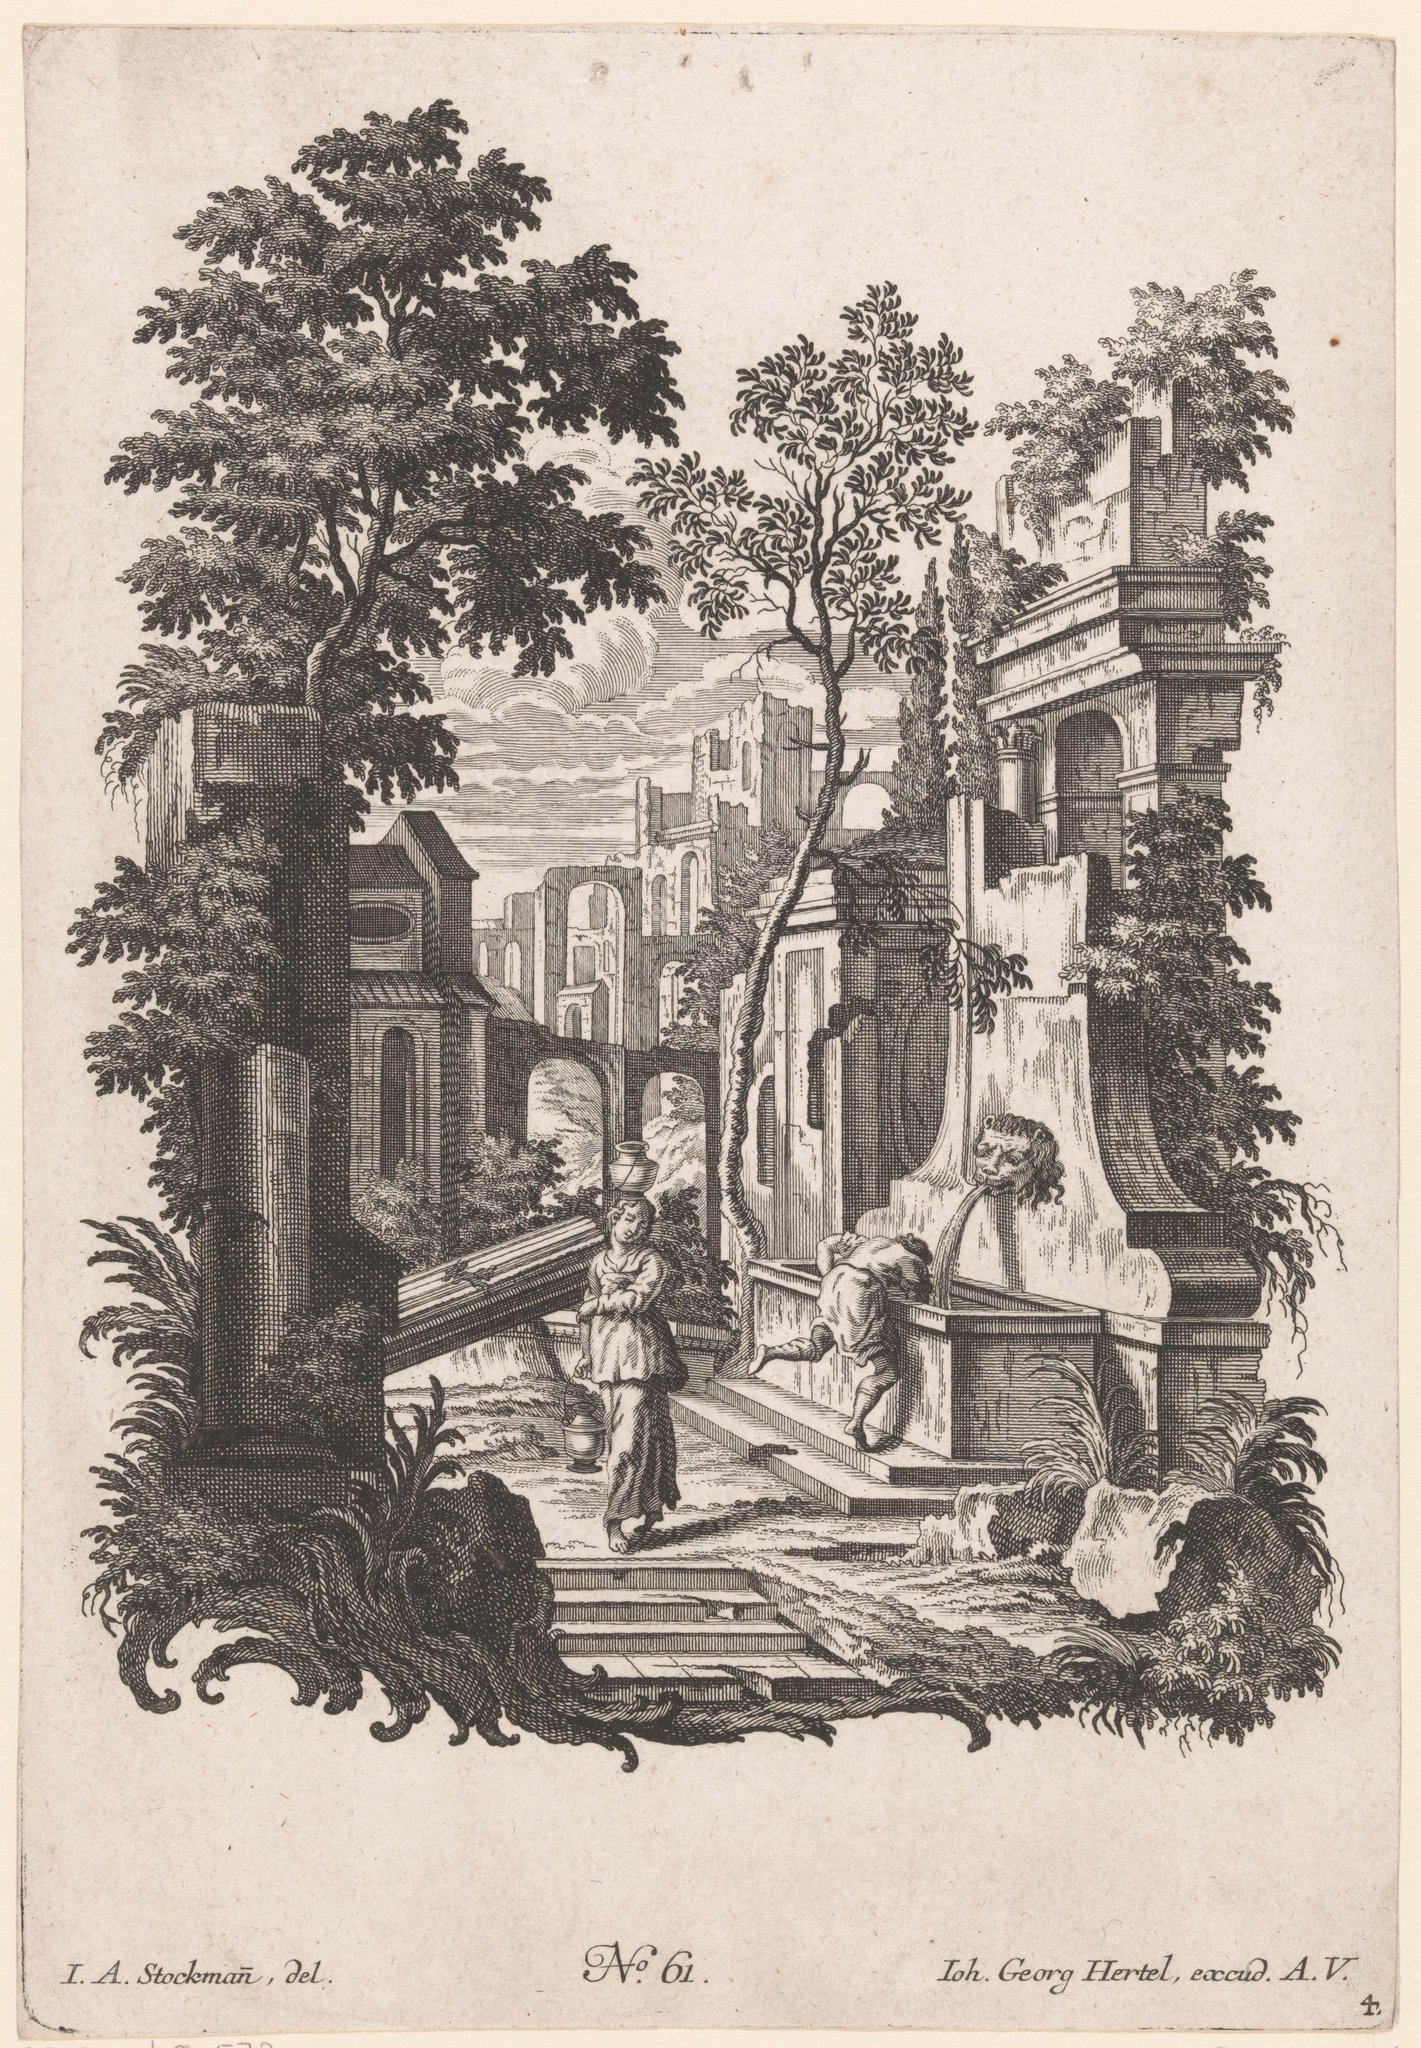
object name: print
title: Ruines Antiques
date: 1750-1799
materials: paper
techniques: etching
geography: augsburg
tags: female sex; woman, jar, jug (used as drinking-vessel), landscape with ruins, ornamental fountain, drinking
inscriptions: collector's mark: Lugt 2760, collector's mark: Lugt 2228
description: Een figuur drinkt uit een fontein met een leeuwenkop in een ruïnelandschap. Links loopt een vrouw met een kruik op haar hoofd en in haar hand. Aan de onderzijde van de voorstelling een rocaille lijst. Uitgeversnummer 61.